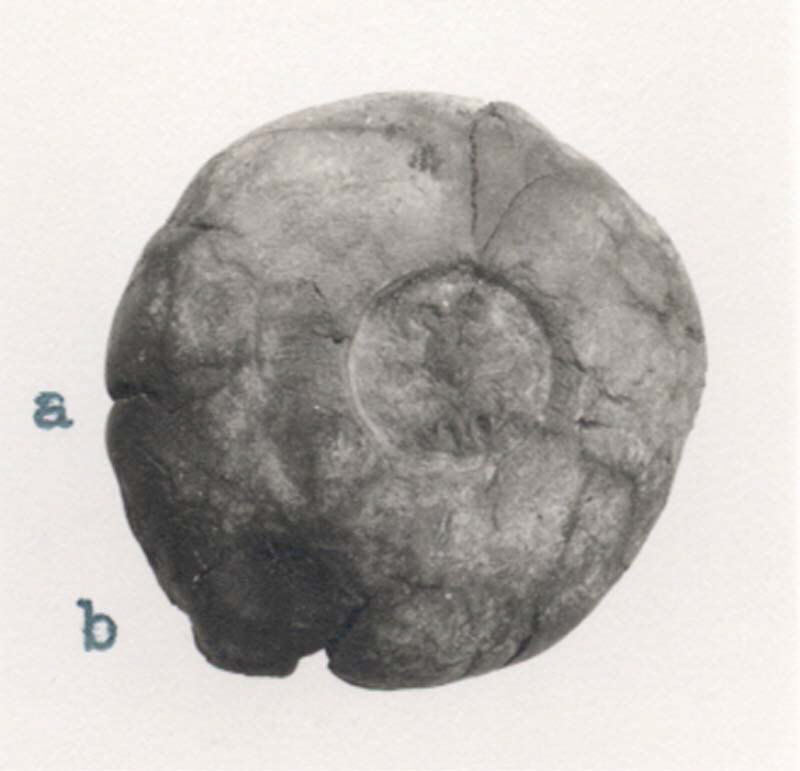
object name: sealing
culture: sasanian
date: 601-700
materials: clay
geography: iran